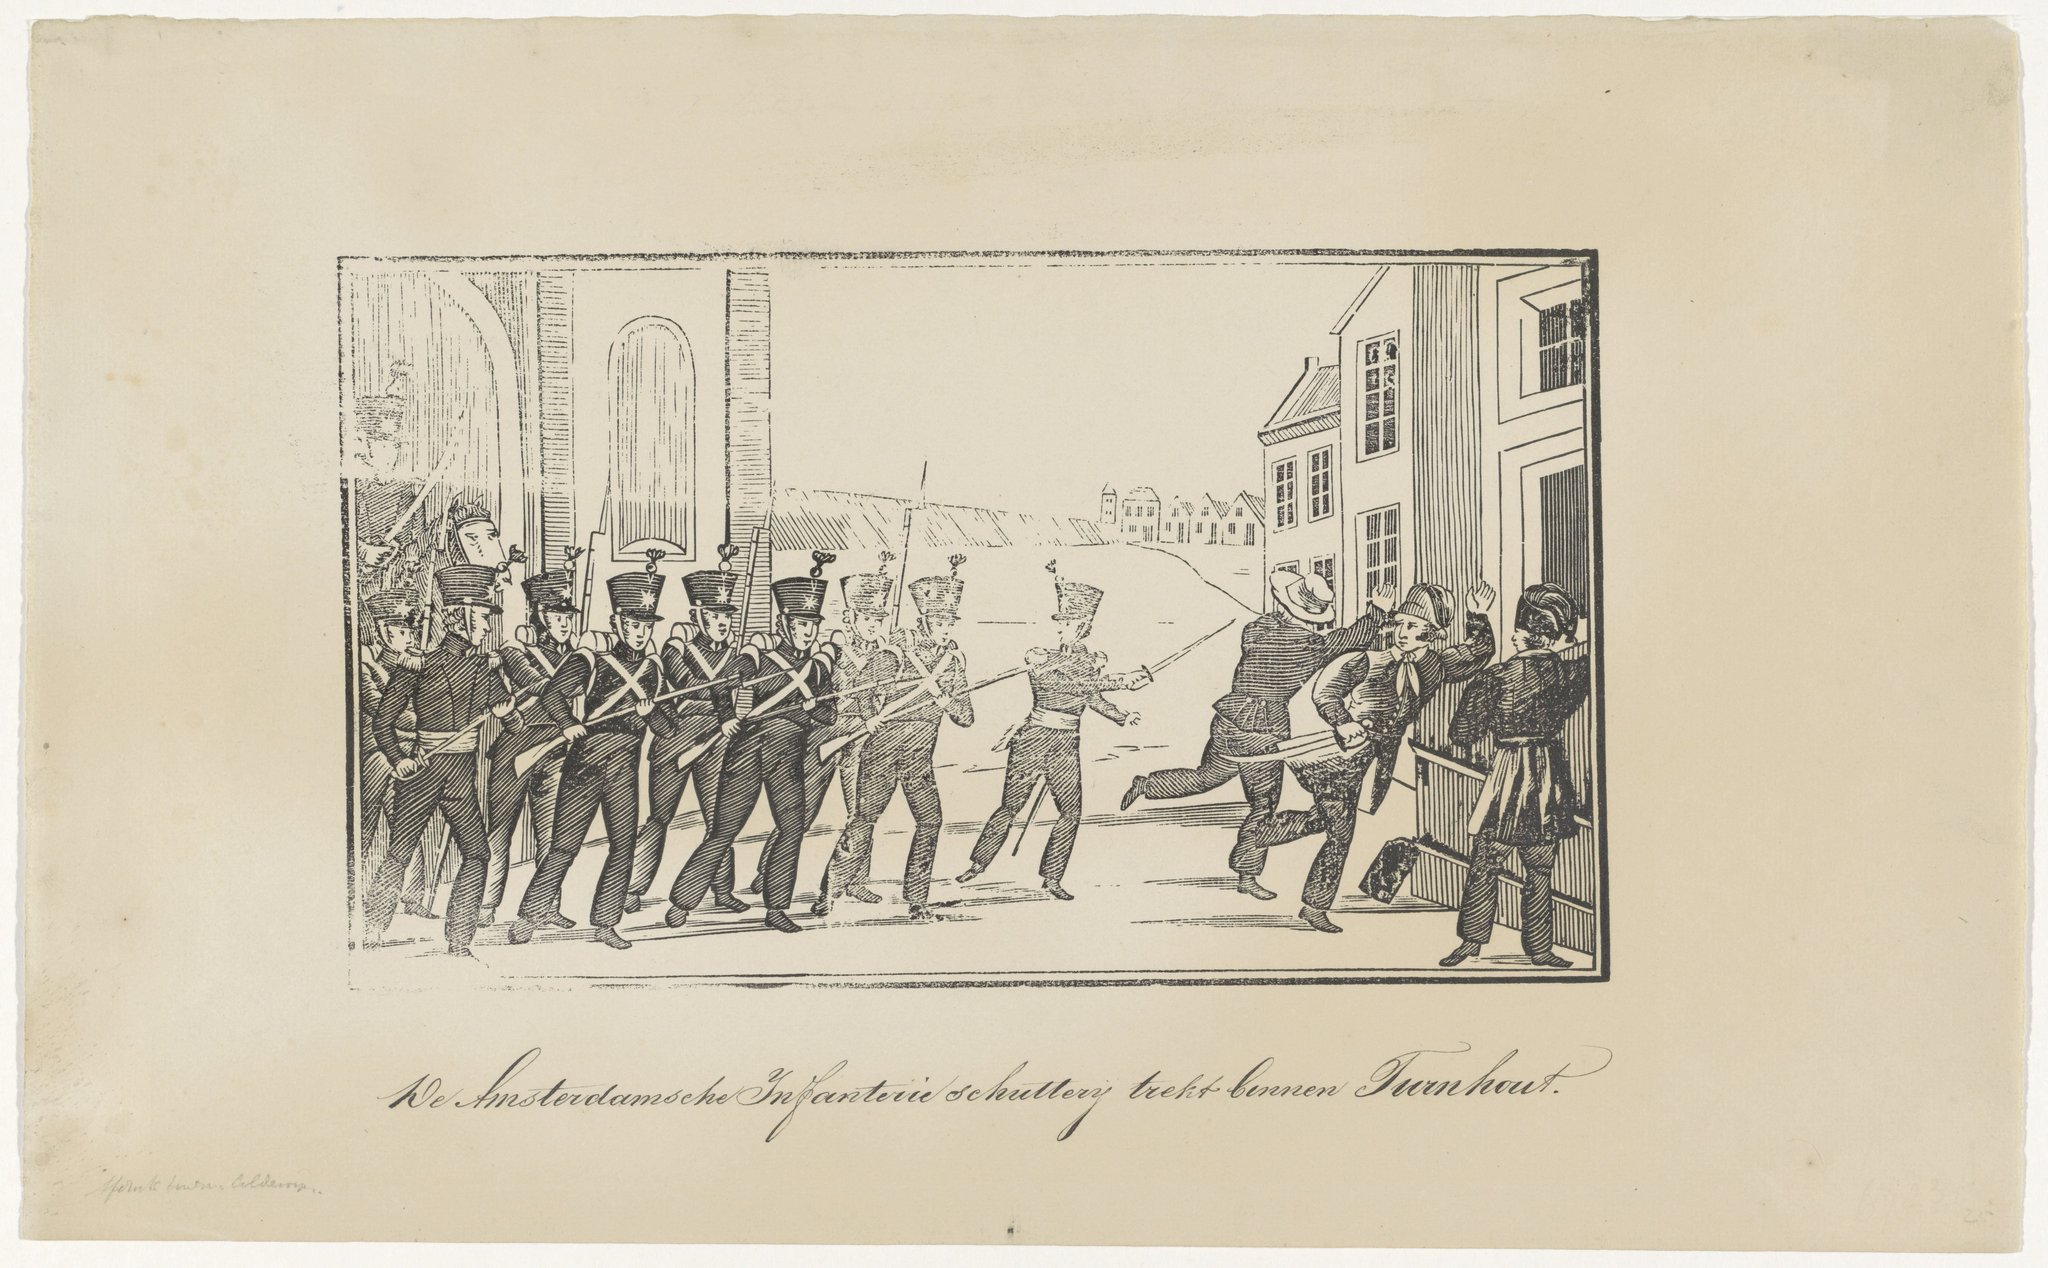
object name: print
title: Amsterdamse schutterij trekt Turnhout binnen, 1831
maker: jacob coldewijn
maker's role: print maker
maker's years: 1796-1855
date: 1831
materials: paper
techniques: woodcut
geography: netherlands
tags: capture of city (after the siege)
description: De Amsterdamse schutterij trekt door de stadspoort Turnhout binnen, 4 augustus 1831. Rechts vluchten enkele inwoners.